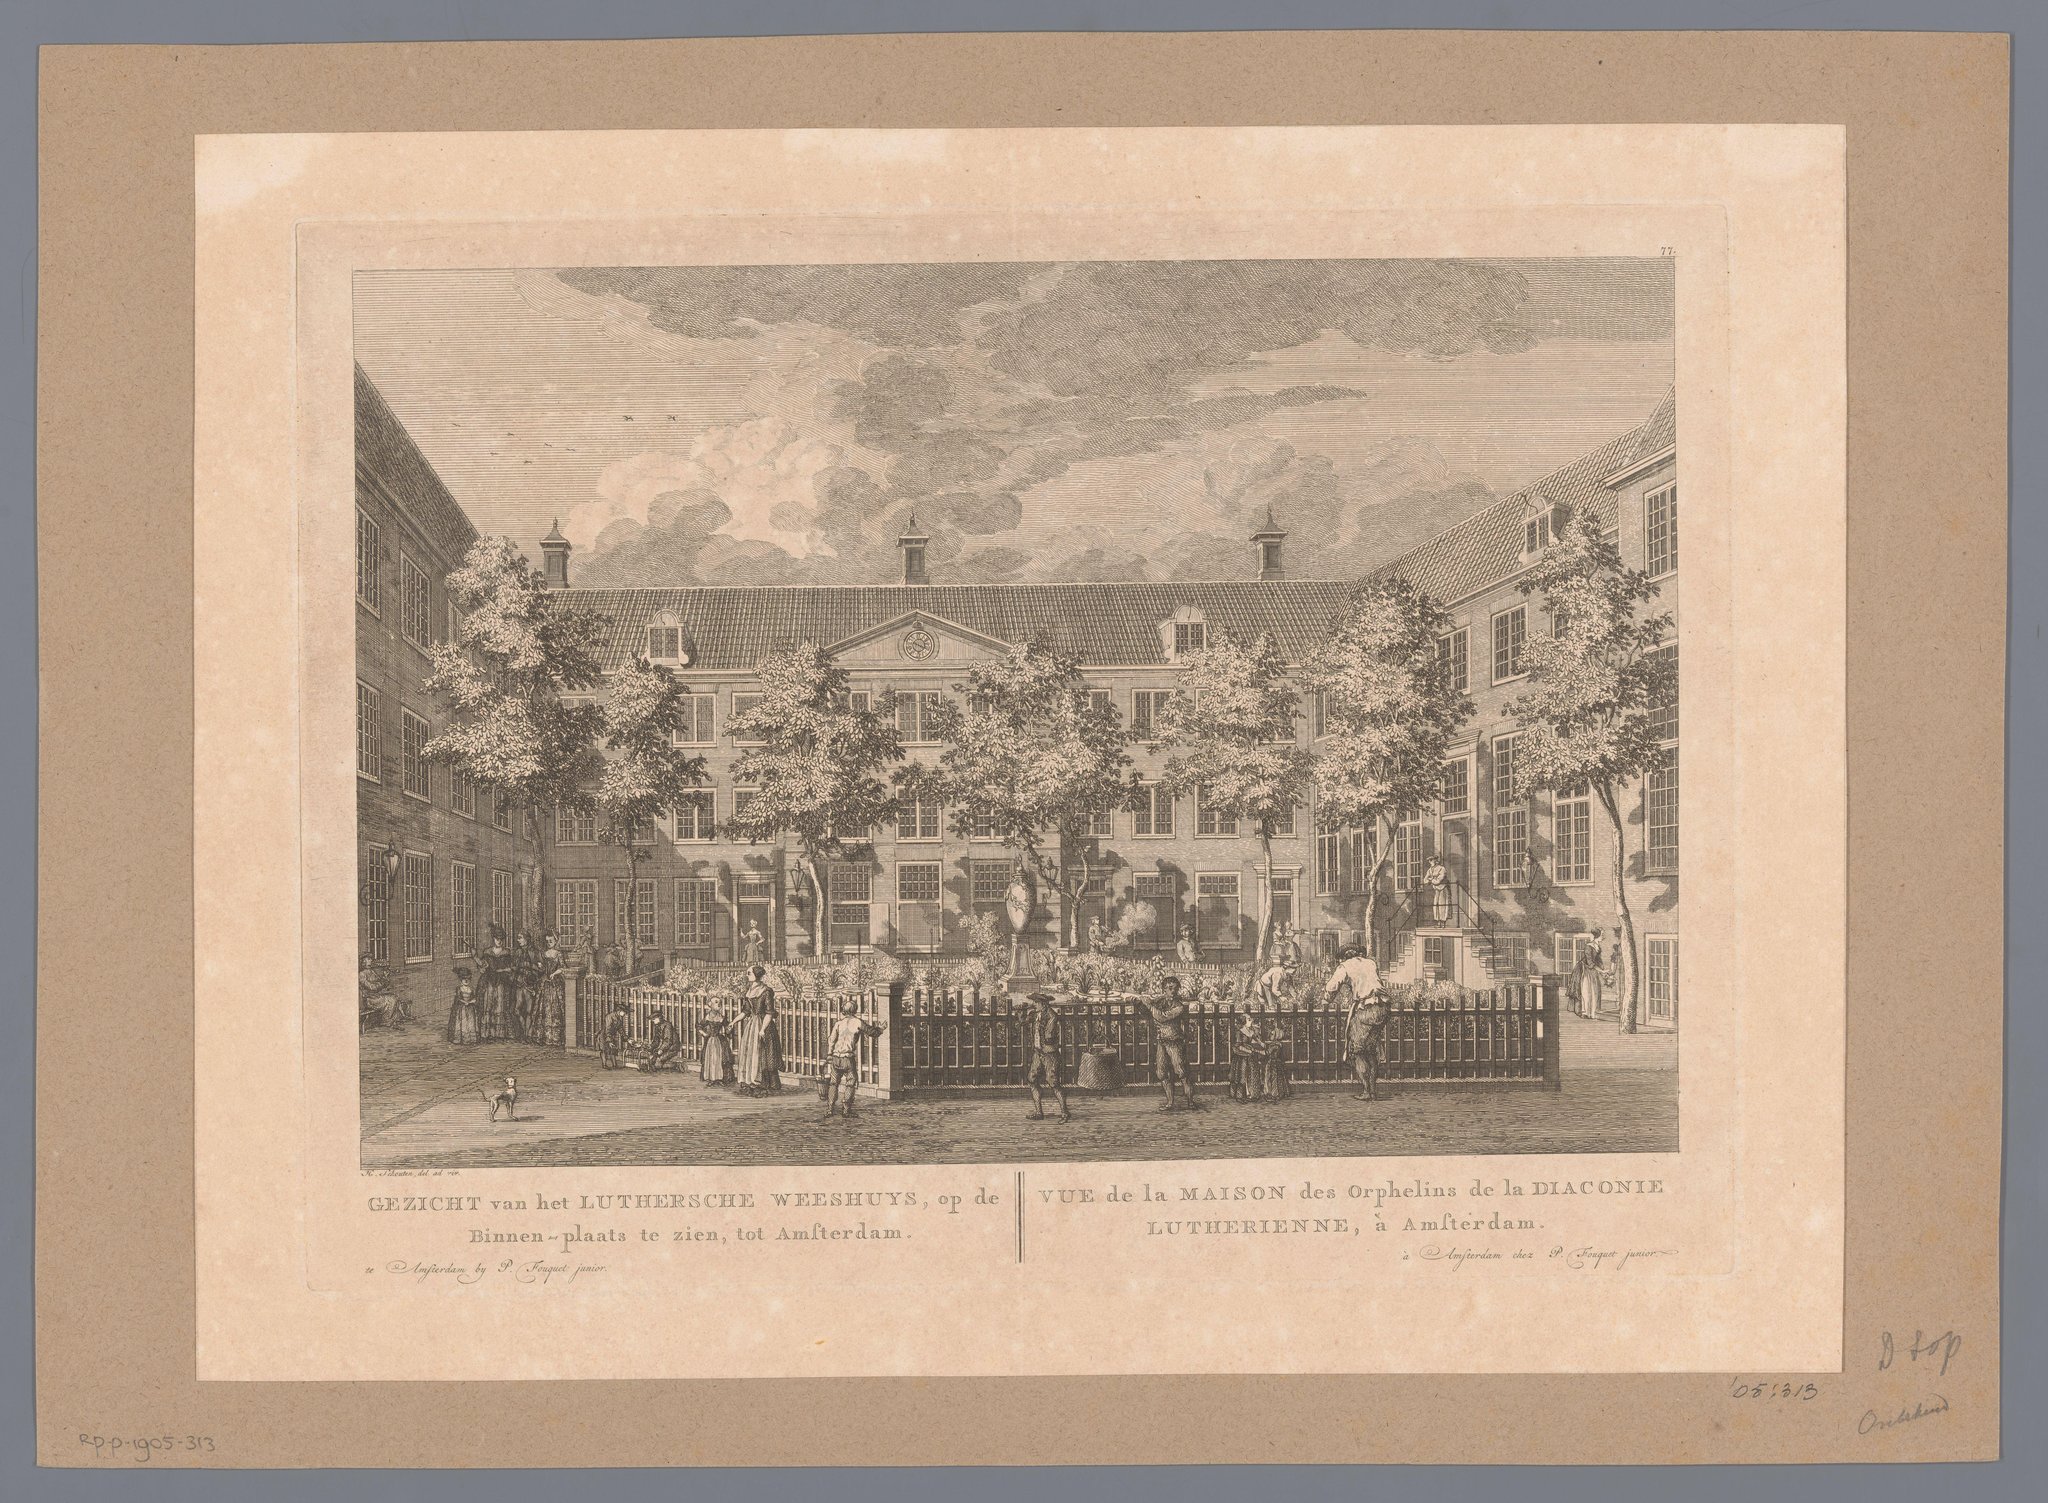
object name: print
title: Gezicht op de binnenplaats van het Lutherse Diaconieweeshuis te Amsterdam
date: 1770-1783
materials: paper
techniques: engraving, etching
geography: amsterdam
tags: fenced or walled garden; 'hortus conclusus', courtyard, orphanage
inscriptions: collector's mark: Lugt 2228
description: Deze prent is ook gebruikt in de zogenaamde Atlas van Fouquet.* Pierre Fouquet gaf vanaf 1760 stadsgezichten van Amsterdam - naar tekeningen van verschillende kunstenaars, gemaakt door verschillende prentmakers - uit. Deze prenten werden aanvankelijk los of in series verkocht. Zoals toen gebruikelijk kon de koper de prenten zelf laten inbinden. Hiertoe gaf Fouquet tussen 1778 en 1783 een titelblad, plattegrond en inhoudsopgave van de tot dusver 100 uitgegeven prenten uit (1). Gezien de inhoud afhankelijk was van wat de koper had verzameld verschilt de inhoud van de verschillende bewaarde Fouquetatlassen onder deze titel sterk. Ook zijn er exemplaren bekend waar tevens andere prenten aan zijn toegevoegd. Omdat er behoefte bleek aan uitleg bij de platen werd in 1783 een nieuwe versie van de atlas uitgegeven, aangevuld met tekst en twee prenten. De aangegeven volgorde veranderde maar de platen van de al eerder uitgegeven prenten bleven ongewijzigd. Deze uitgave werd in opdracht van Fouquet gedrukt bij Daniël Jean Changuion en Petrus den Hengst (2). Een tiental platen werd bijgewerkt en verscheen, met nieuw impressum, in het vervolg van Wagenaars geschiedenis van Amsterdam, uitgeven door Petrus Conradi en Folkert van der Plaats (3). Een aantal jaar na het overlijden van Fouquet kwam Evert Maaskamp met een nieuwe uitgave van de atlas, met verbeterde tekst en toevoeging van twee prenten. Op alle platen verwijderde hij het oude en liet hij zijn eigen impressum zetten (4). De huidige staat van de prent komt voor in exemplaren van de onder (1) en (2) genoemde werken. * Onder de Atlas van Fouquet of Fouquetatlas verstaan we de hieronder vermelde publicaties (1), (2) en (4). (1). Afbeeldingen van de wyd-vermaarde koopstad Amsterdam benevens des zelvs voornaamste gebouwen en gezigten alle naar het leeven getekend / Receuil des edifices les plus considerables et des plus belles vues, de la fameuse ville d'Amsterdam, dessinées d'après nature. Amsterdam: Pierre Fouquet, 1778-1783. (2). Nieuwe atlas, van de voornaamste gebouwen en gezigten der stad Amsterdam, met derzelver beknopte beschryvingen. 2 delen. Amsterdam: Daniël Jean Changuion en Petrus den Hengst [in opdracht van Pierre Fouquet], 1783. (3). Stijl, Simon. Amsterdam, in zyne geschiedenissen, voorregten, koophandel, gebouwen, kerkenstaat, schoolen, schutterye, gilden en regeeringe, beschreeven. Om te dienen ten vervolge op het werk van Jan Wagenaar (…). 10 delen. Amsterdam en Harlingen: Petrus Conradi en Folkert van der Plaats, 1788-1801. (4). Nieuwe atlas, van de voornaamste gebouwen en gezigten der stad Amsterdam. Met derzelver beknopte beschryvingen. Amsterdam: Evert Maaskamp, 1805. * Het aantal vermelde staten is gebaseerd op het aantal gevonden staten. Mogelijk zijn er meer staten van deze prent. Zie RP-P-1998-764 voor derde bekende staat.